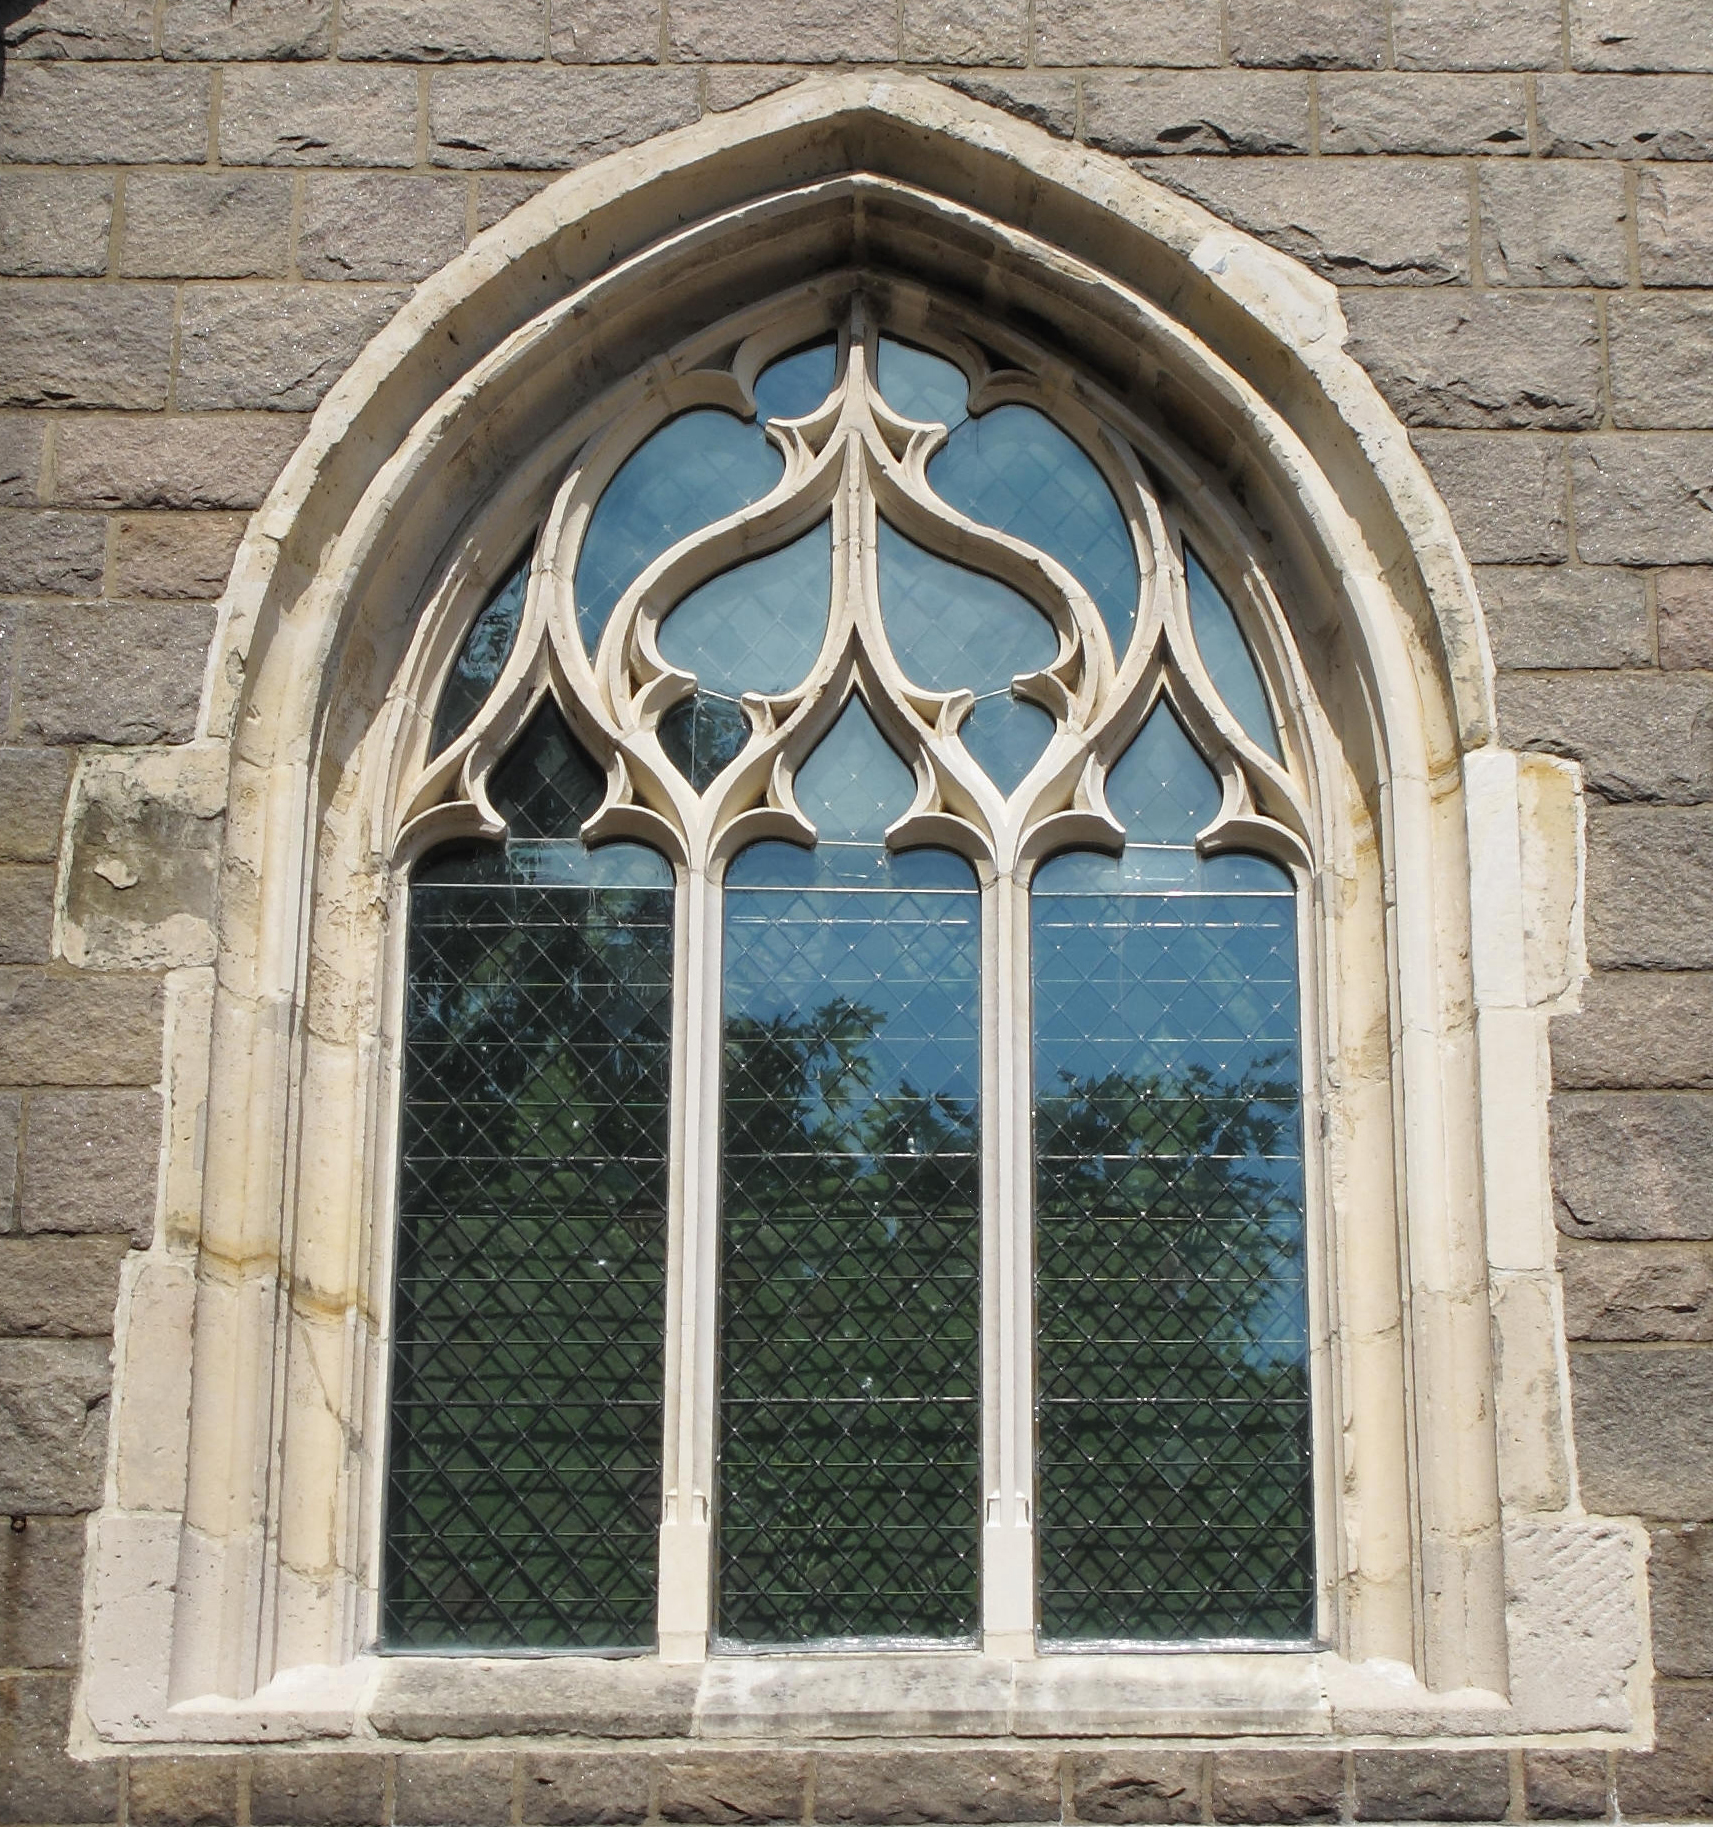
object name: window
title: Window with Flamboyant Tracery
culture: french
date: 1401-1500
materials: limestone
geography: france